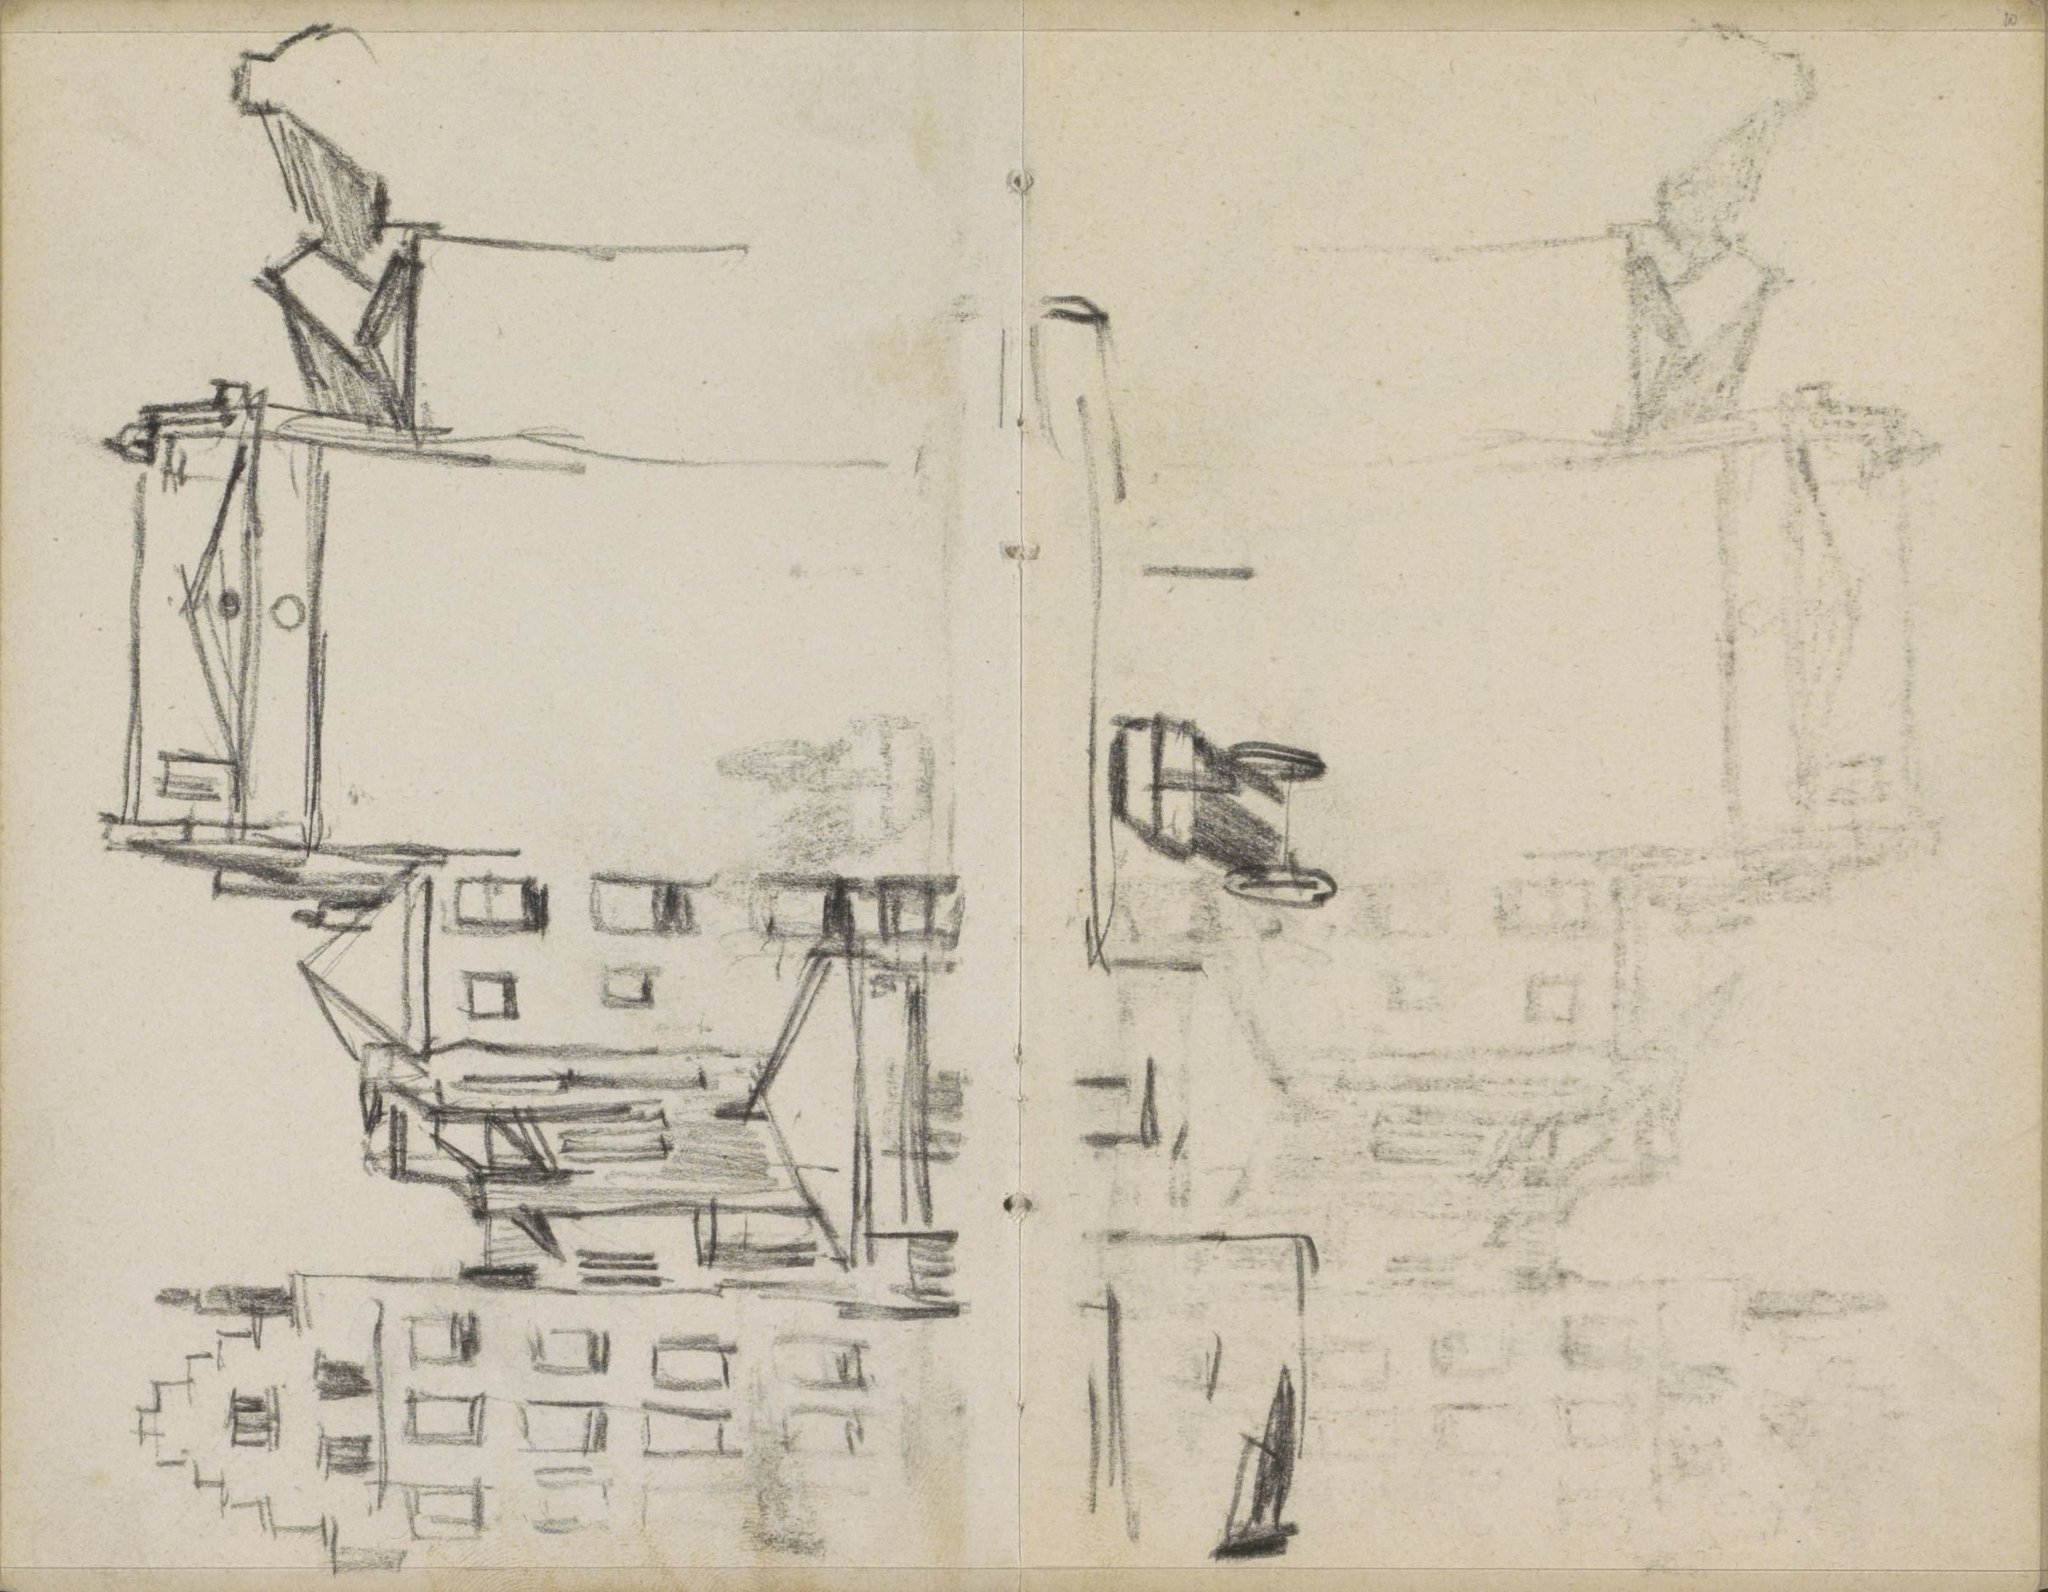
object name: sketchbook leaf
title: Gezicht op het Damrak te Amsterdam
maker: george hendrik breitner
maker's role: draughtsman, painter, print maker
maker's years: 1857-1923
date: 1902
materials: chalk, paper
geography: amsterdam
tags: canals, waters (in city), civic architecture; edifices; dwellings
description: Het gebouw met het fronton is het Theemagazijn van Snel, Warmoesstraat 34. Ernaast Lederhandel Van Beugen op nummer 38. Pagina 9 en pagina 10 uit een schetsboek met 46 bladen vervaardigd in de omgeving van Amsterdam, Rotterdam en Haarlem.